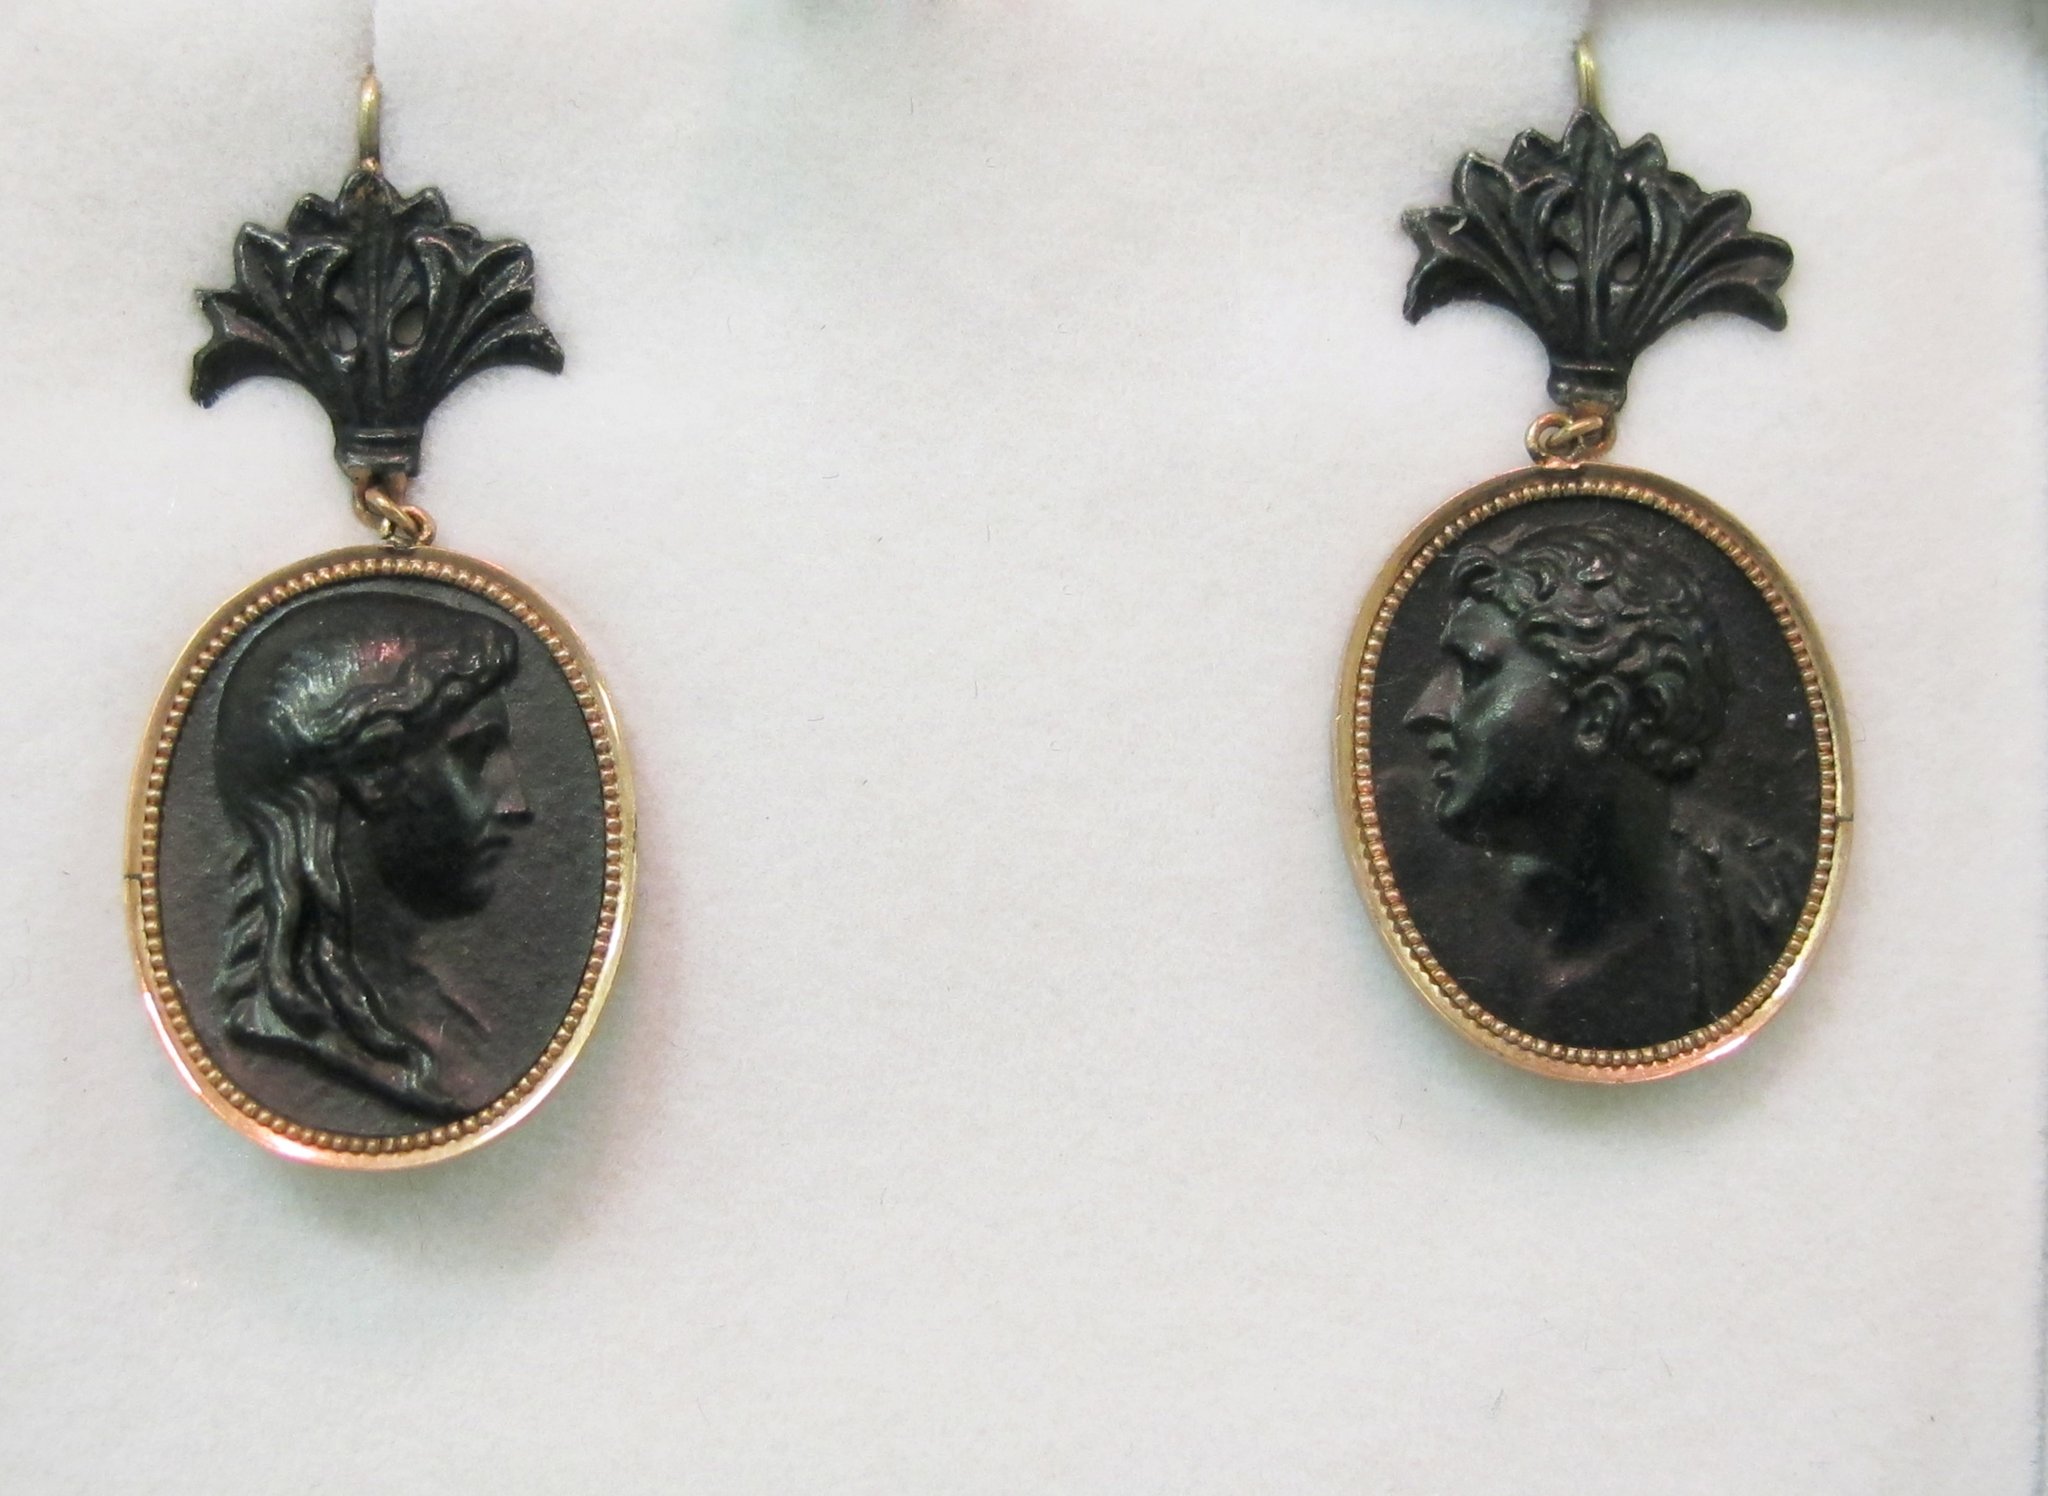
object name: earring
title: Earrings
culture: german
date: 1810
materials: gold, iron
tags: men